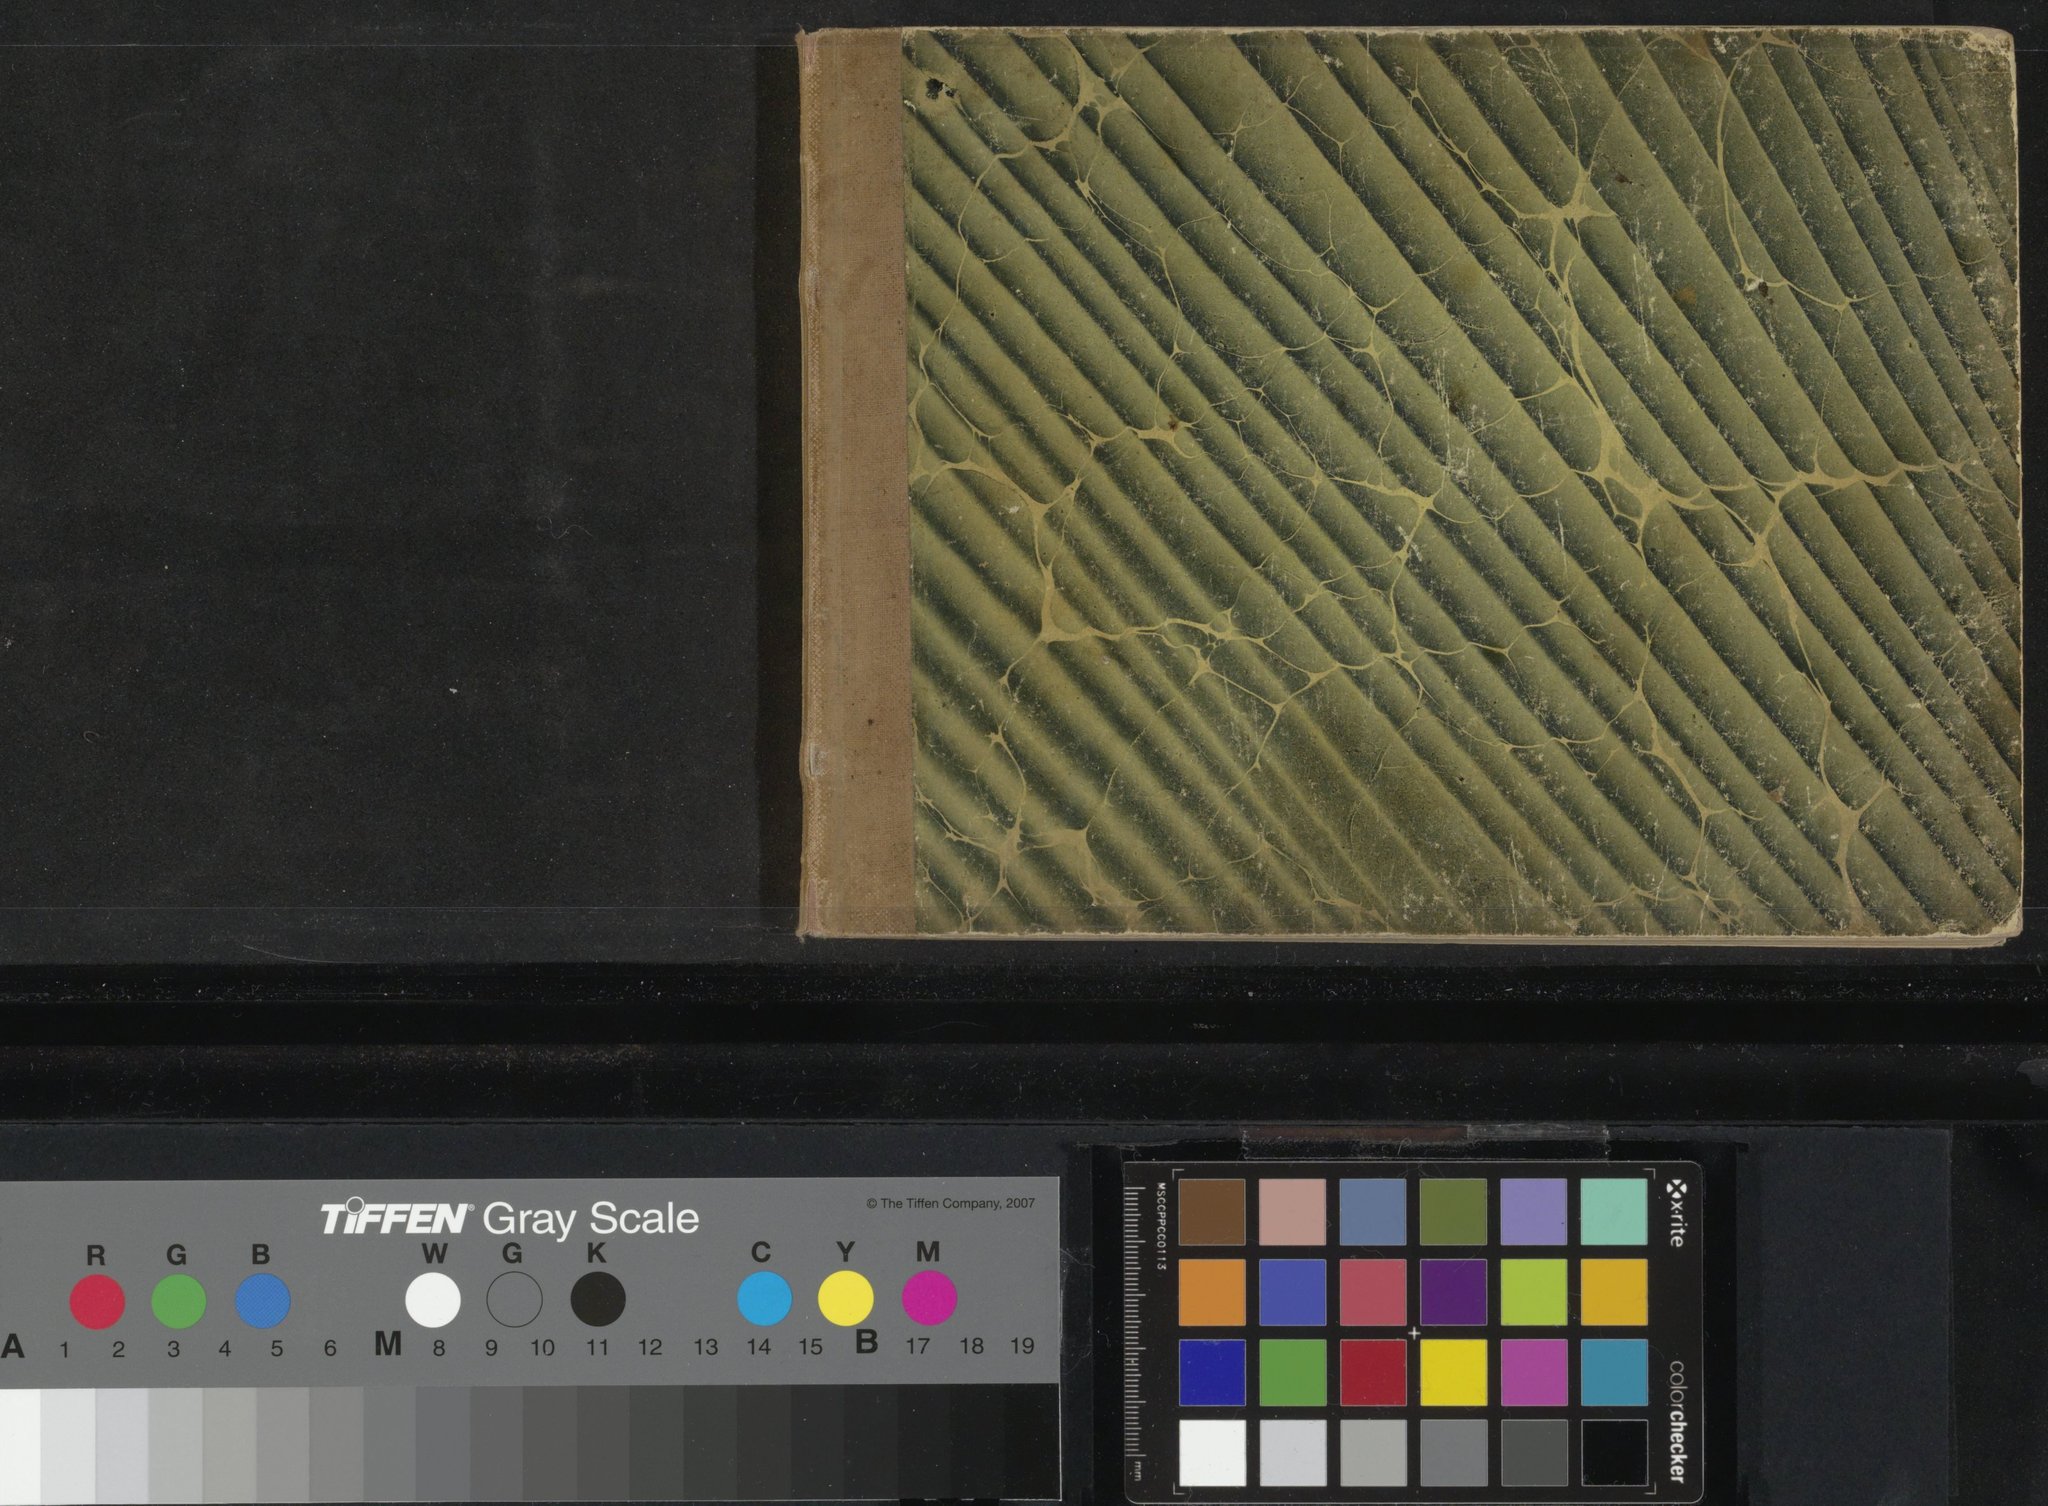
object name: sketchbook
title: Schetsboek met 41 bladen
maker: adrianus eversen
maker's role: draughtsman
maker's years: 1818-1897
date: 1828-1897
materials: paper, pencil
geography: netherlands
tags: urban housing, city-view, and landscape with man-made constructions, landscapes, maastricht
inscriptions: collector's mark: Lugt 2228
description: Schetsboek bestaande uit 41 bladen met stadsgezichten, gebouwen en landschappen.